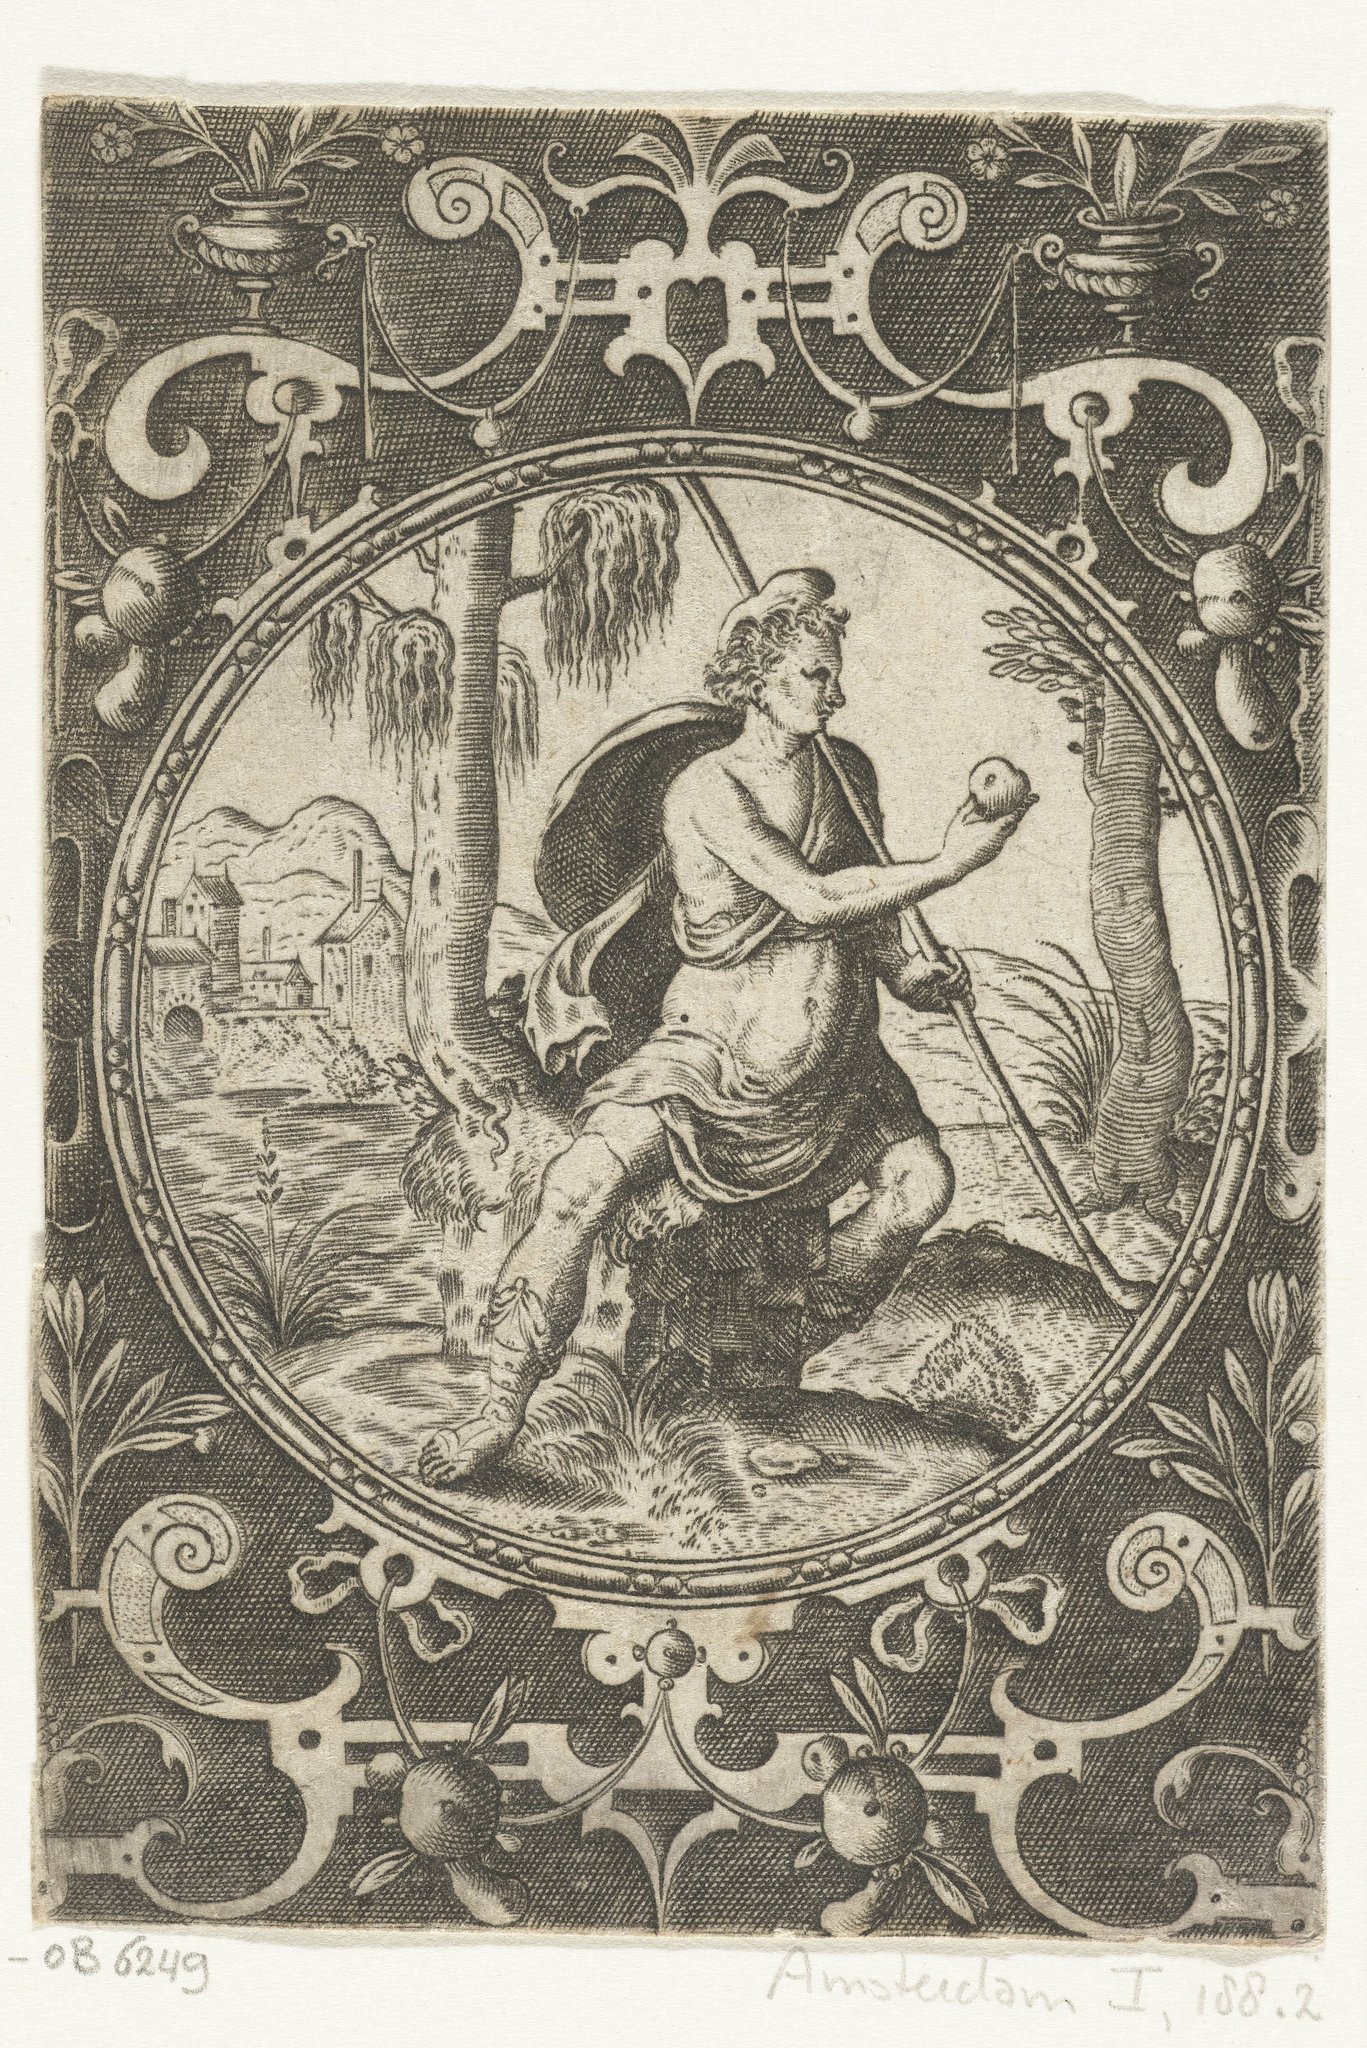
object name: ornament print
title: Medaillons met figuren uit het oordeel van Paris in een omlijsting van beslagwerk met guirlandes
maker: Anonymous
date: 1500-1600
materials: paper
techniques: engraving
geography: netherlands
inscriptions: collector's mark: Lugt 240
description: In de omlijsting linksboven en rechtsboven een vaas met twee bloemen. Gearceerde achtergrond. Eén van 3 bladen.